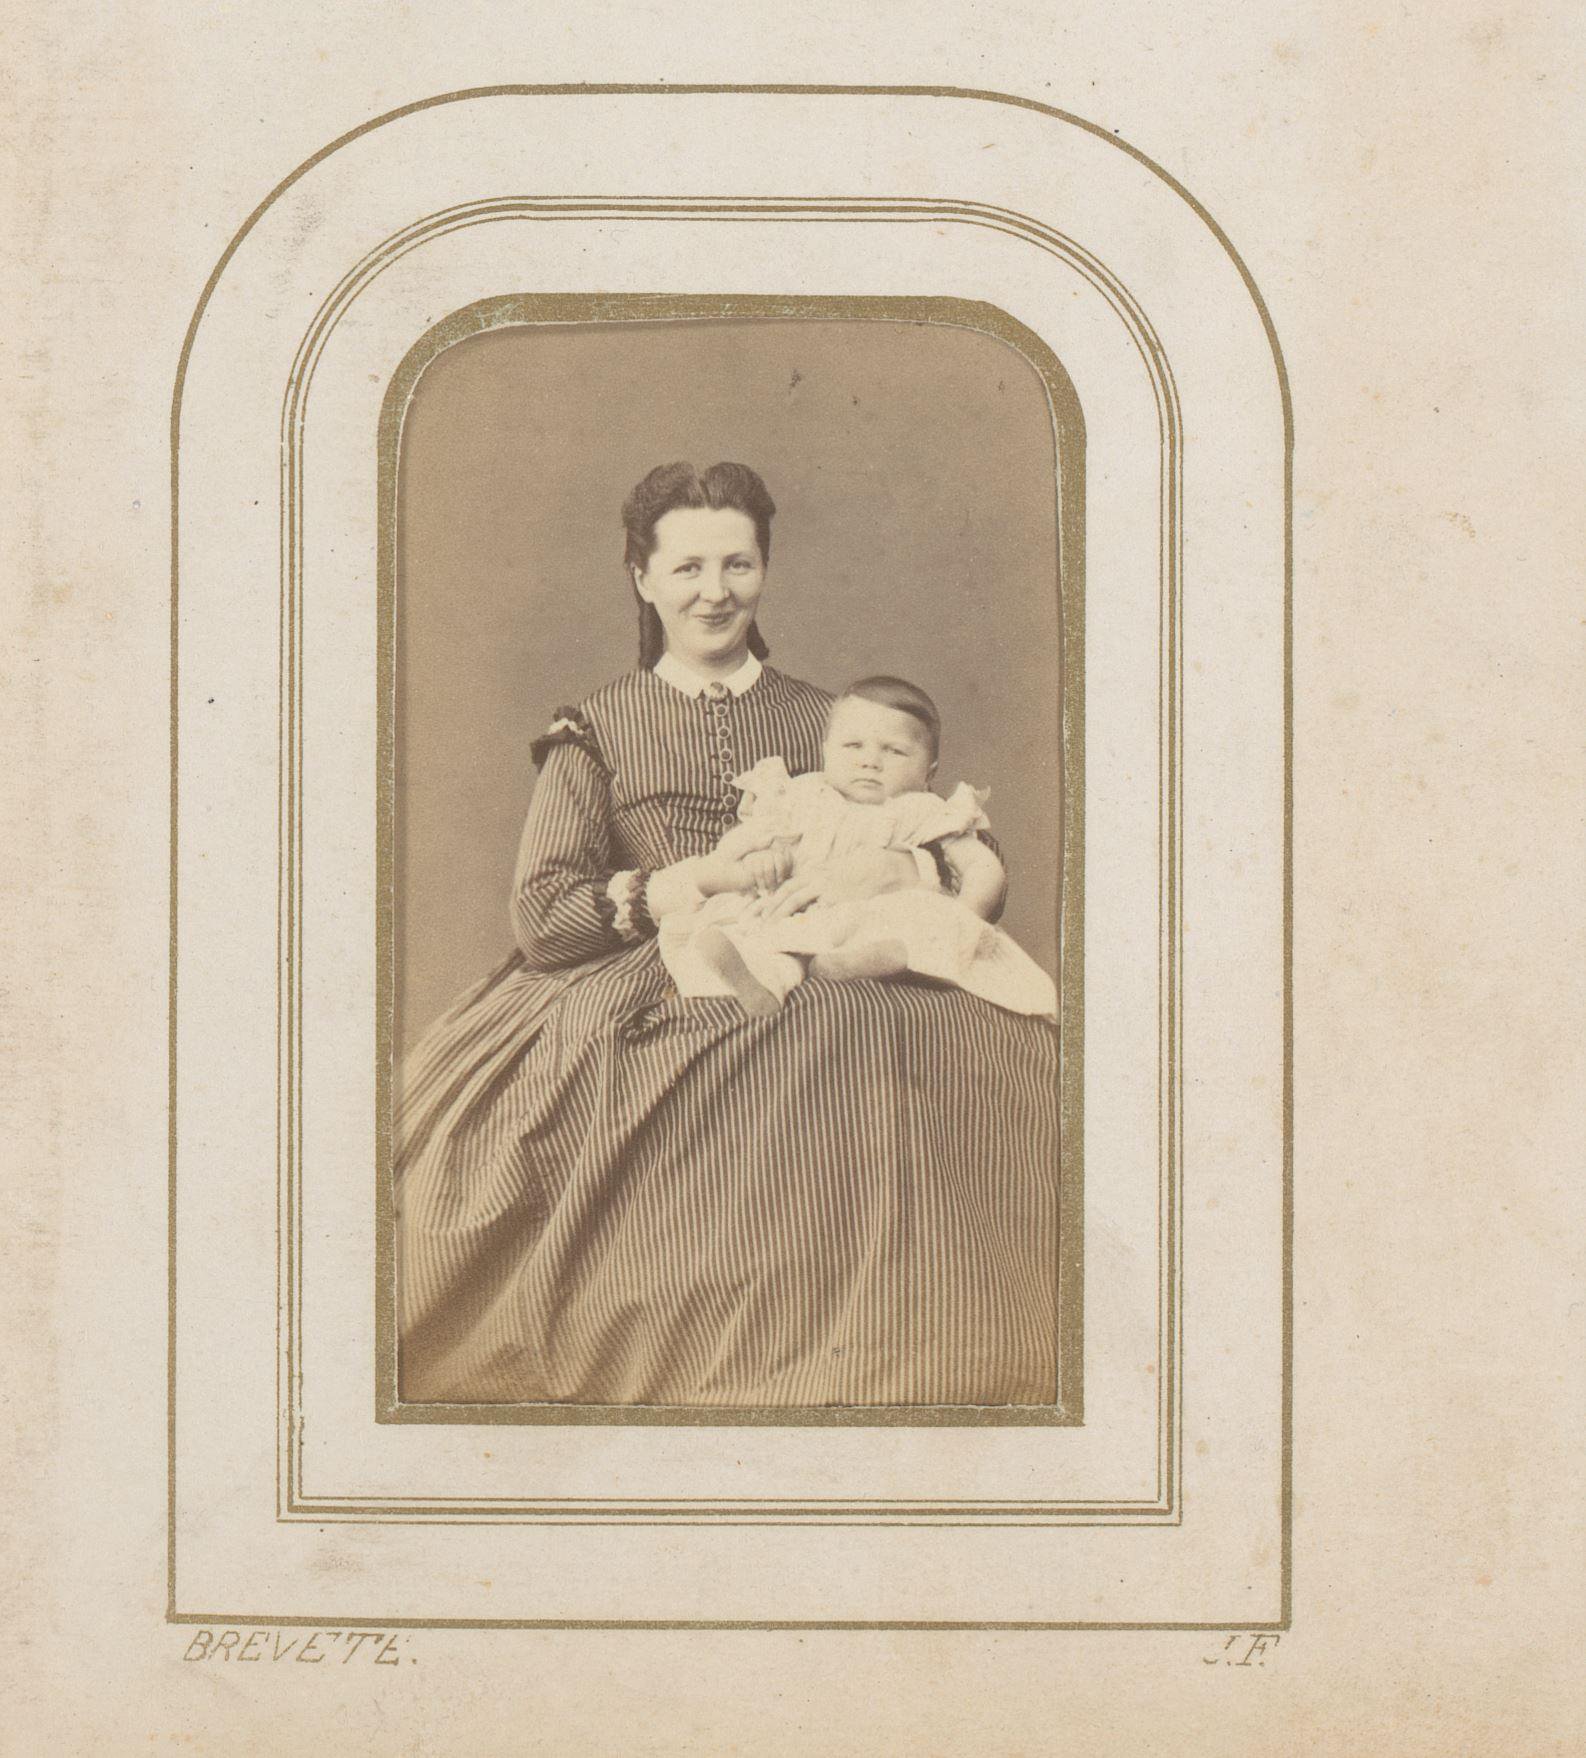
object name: album leaf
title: Portret van een moeder met kind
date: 1860-1880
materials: cardboard, photographic support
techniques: albumen print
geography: brussels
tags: mother and baby or young child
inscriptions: inscription: ‘Photographie Parisienne/ 36, Rue Fossé-aux-Loups/ (Place de la Monnaie)/ Bruxelles’